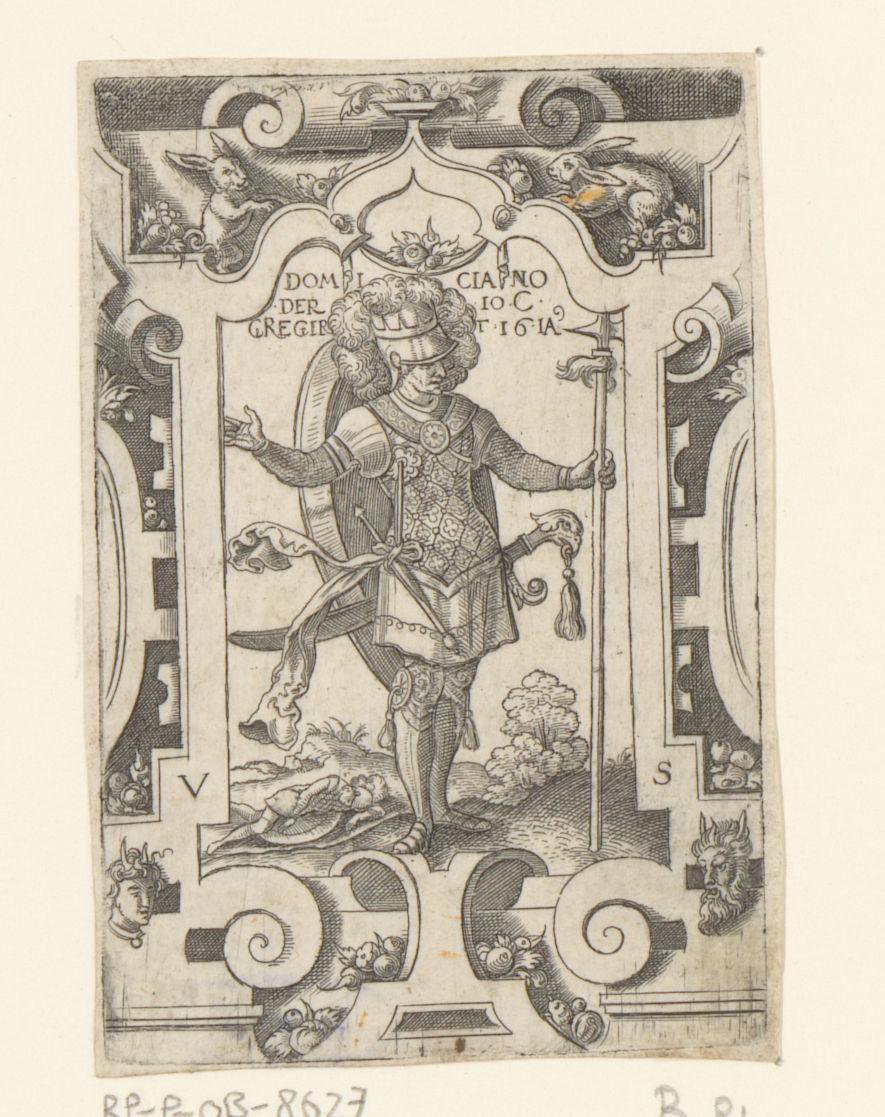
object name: print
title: Eerste twaalf Romeinse keizers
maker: virgilius solis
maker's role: draughtsman, print maker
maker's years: 1514-1562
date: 1524-1562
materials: paper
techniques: engraving, etching, intaglio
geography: nuremberg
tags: male persons from classical history (domitianus, titus flavius) - portrait of person from classical history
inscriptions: number: ‘125’, collector's mark: Lugt 2228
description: Deze prent maakt deel uit van een serie bestaande uit twaalf prenten met de eerste Romeinse keizers staand in rolwerk omlijstingen. In de collectie van het Rijksmuseum bevinden zich elf van de twaalf prenten.